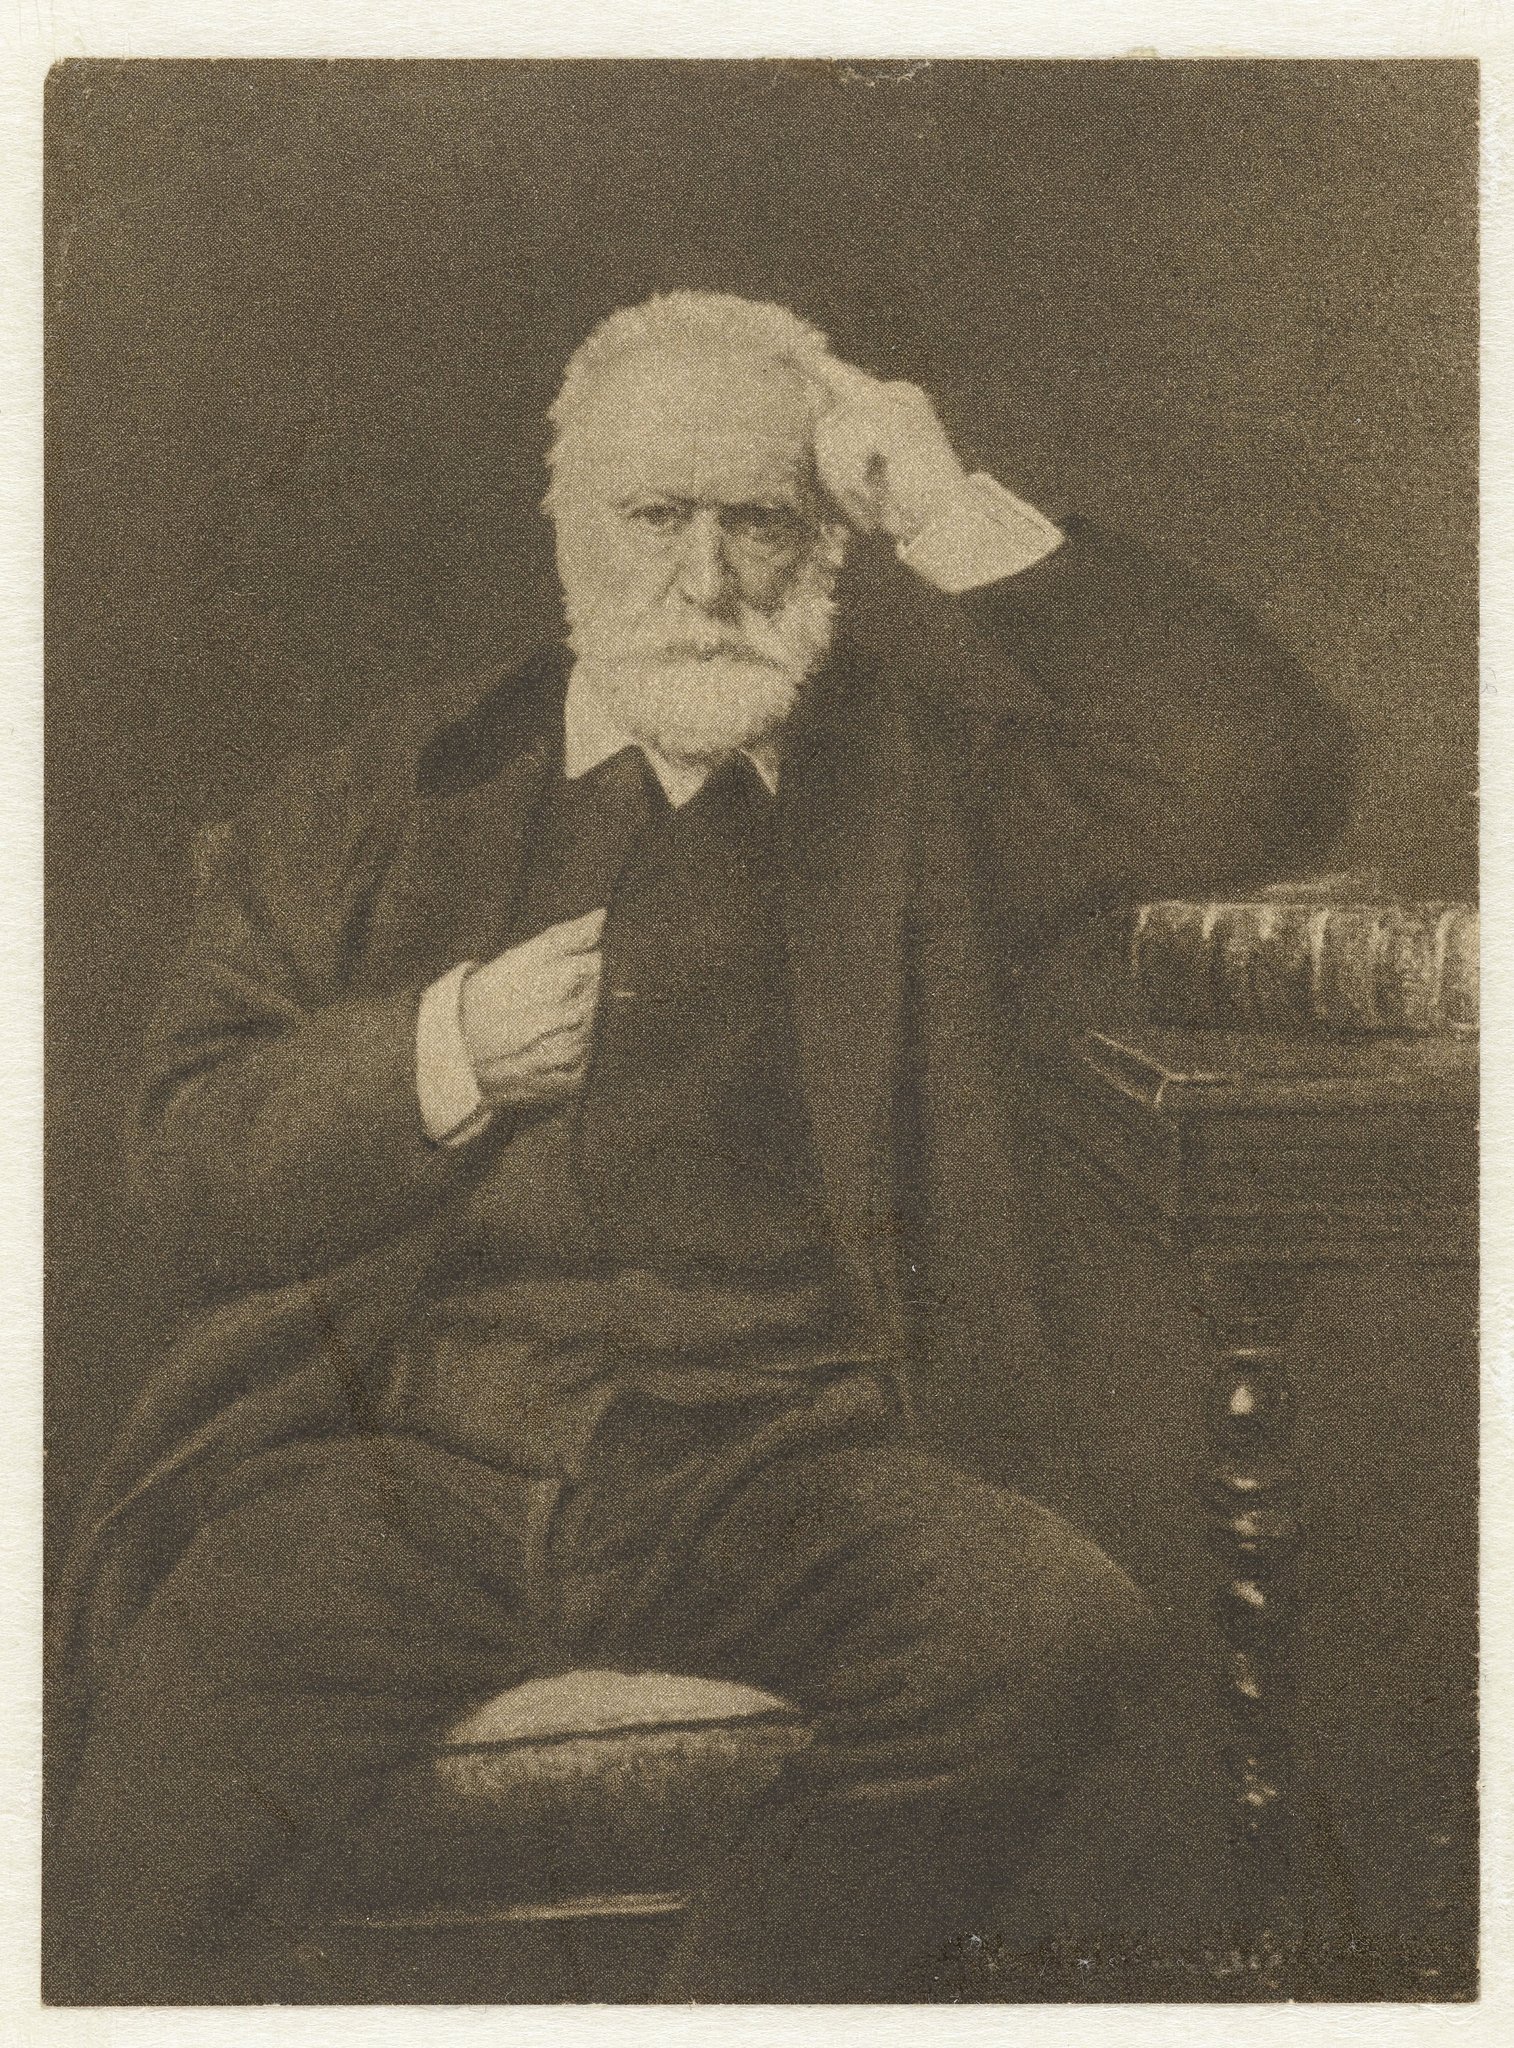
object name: photomechanical print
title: Portret van Victor Hugo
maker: Anonymous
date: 1895-1930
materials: paper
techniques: rotogravure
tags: victor hugo, adult man, historical persons